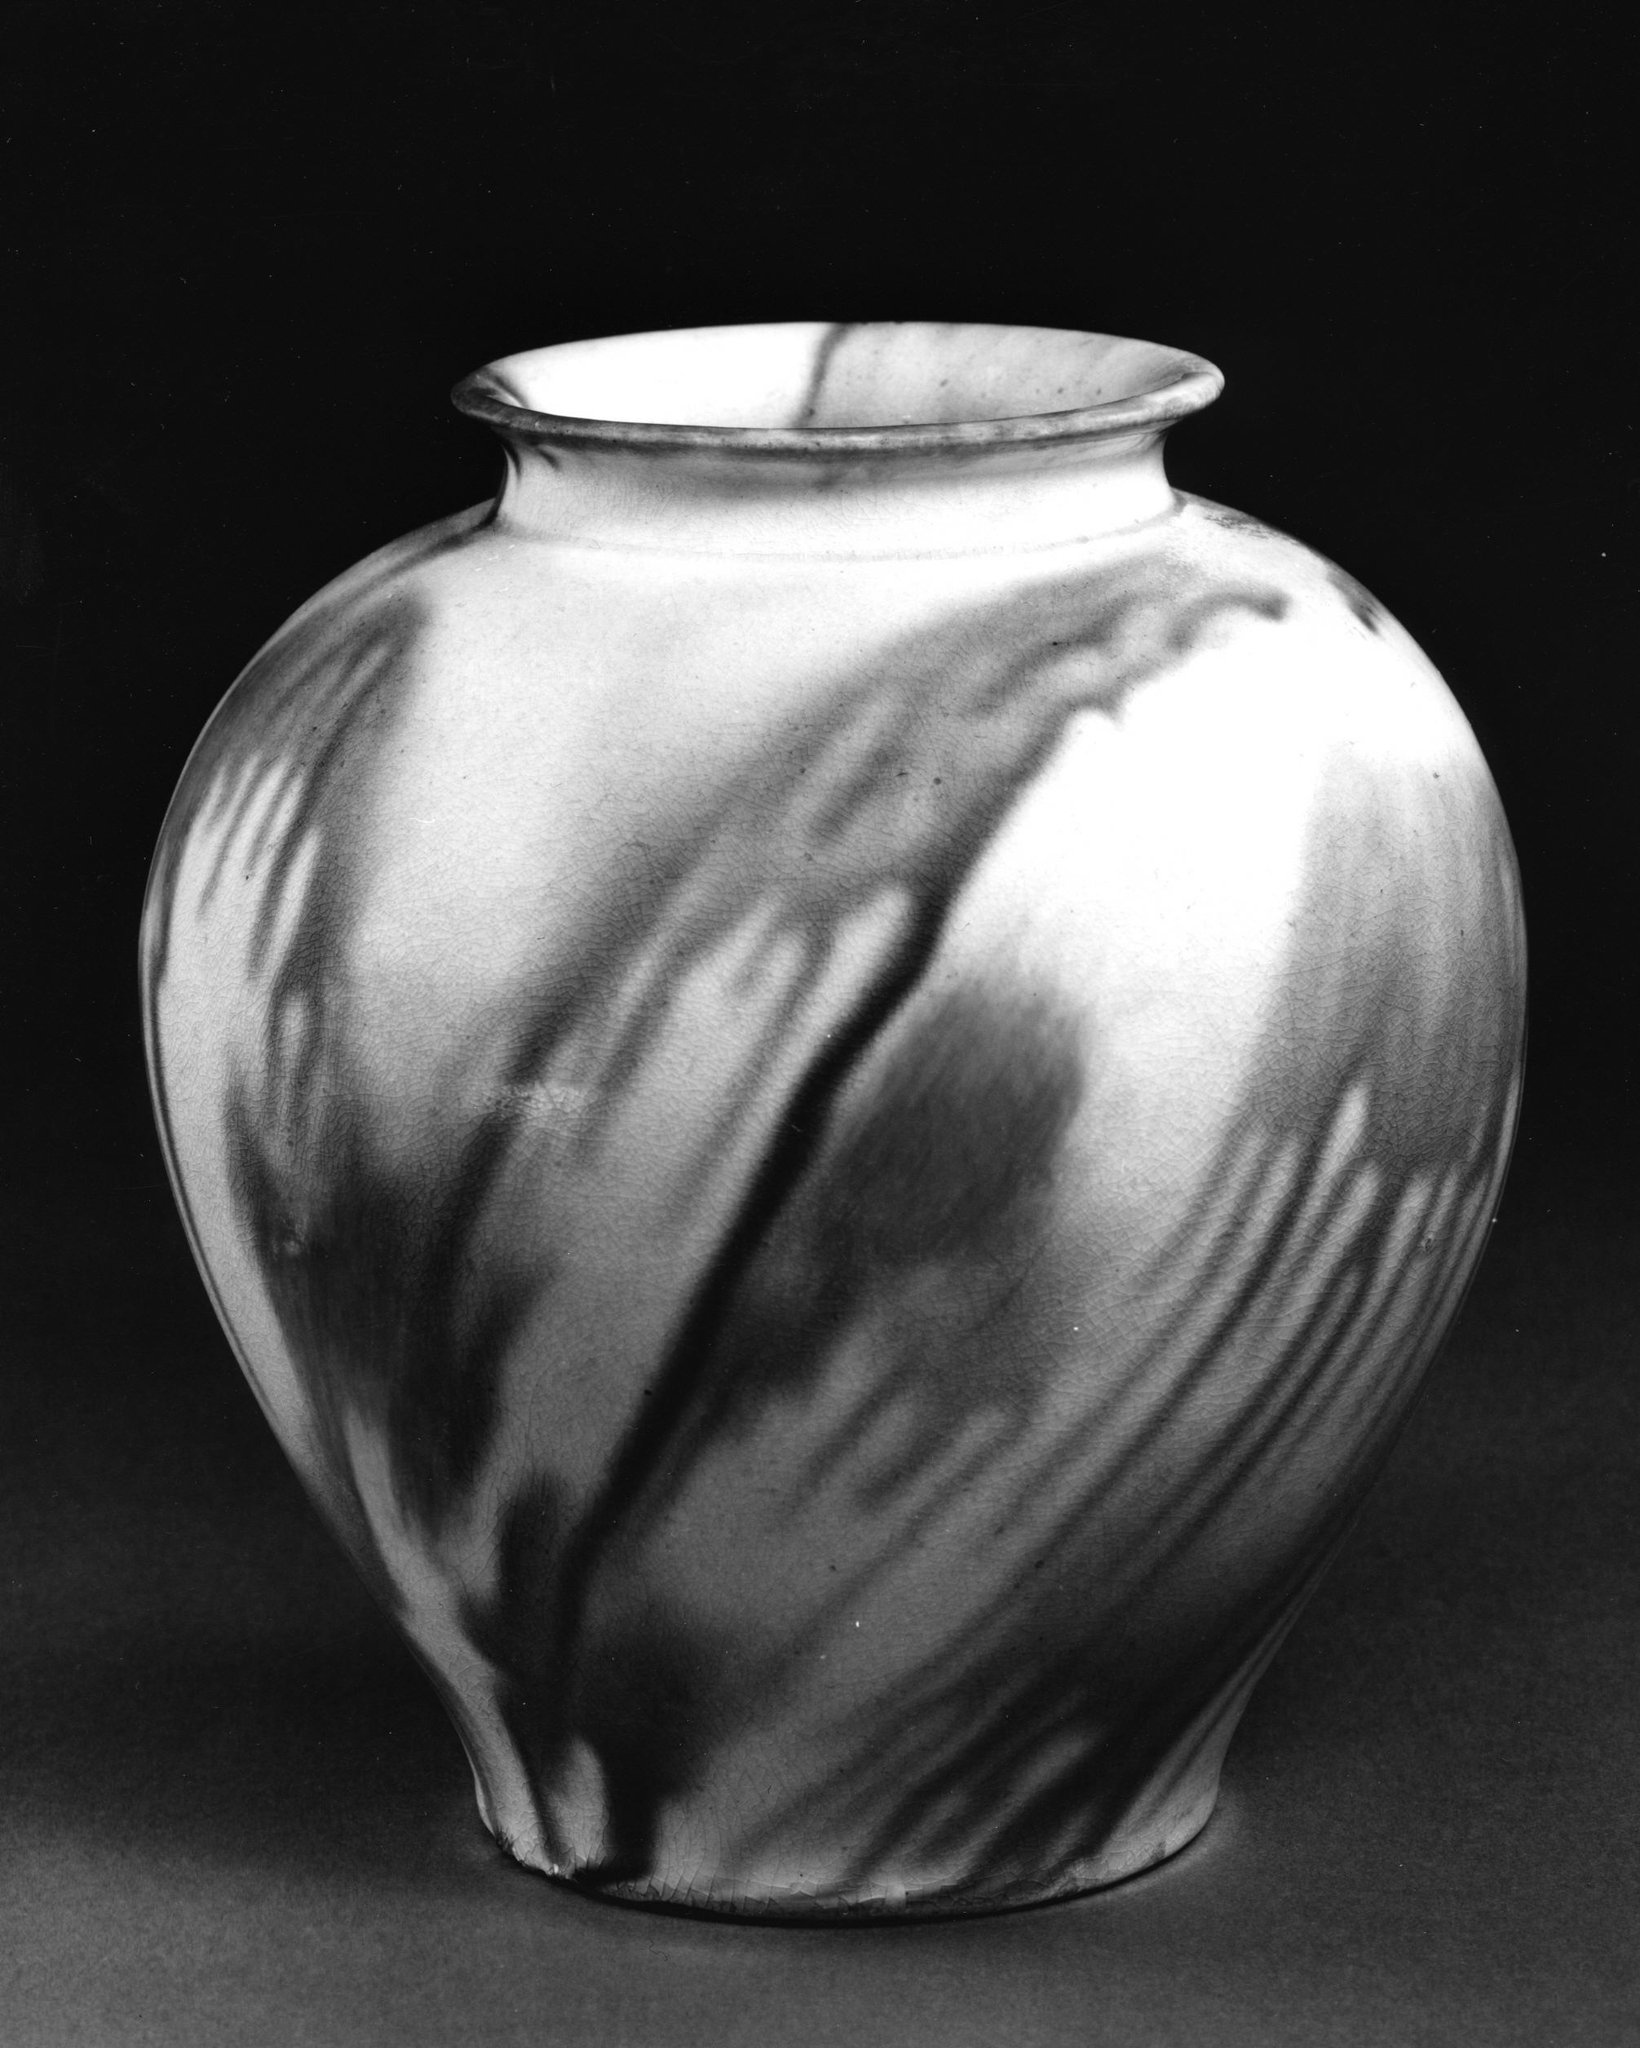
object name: jar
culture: chinese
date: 701-750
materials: earthenware, glaze